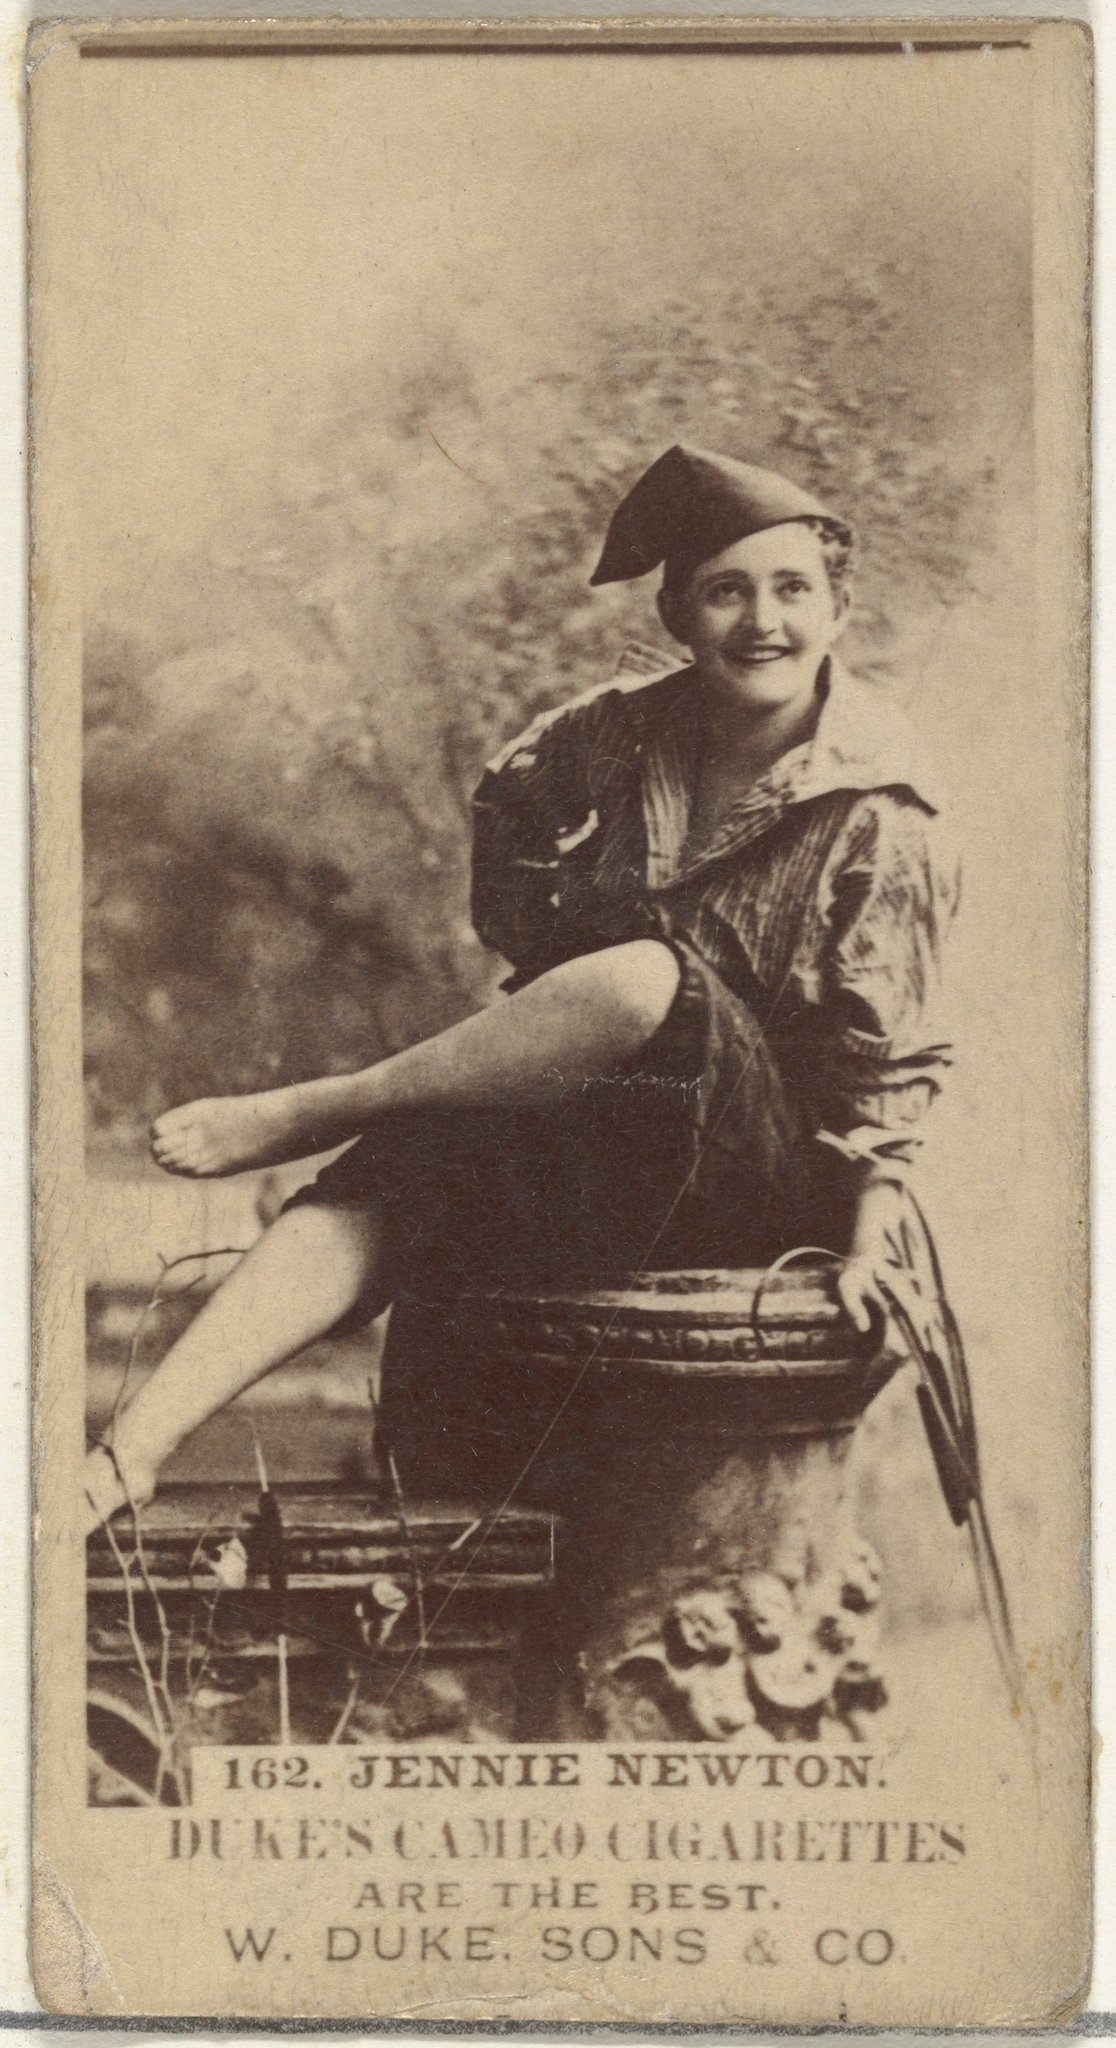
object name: photograph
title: Card Number 162, Jennie Newton, from the Actors and Actresses series (N145-5) issued by Duke Sons & Co. to promote Cameo Cigarettes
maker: w. duke, sons & co.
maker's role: publisher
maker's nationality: american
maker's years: 1870-1920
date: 1880-1889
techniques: albumen silver print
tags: portraits,women,actresses